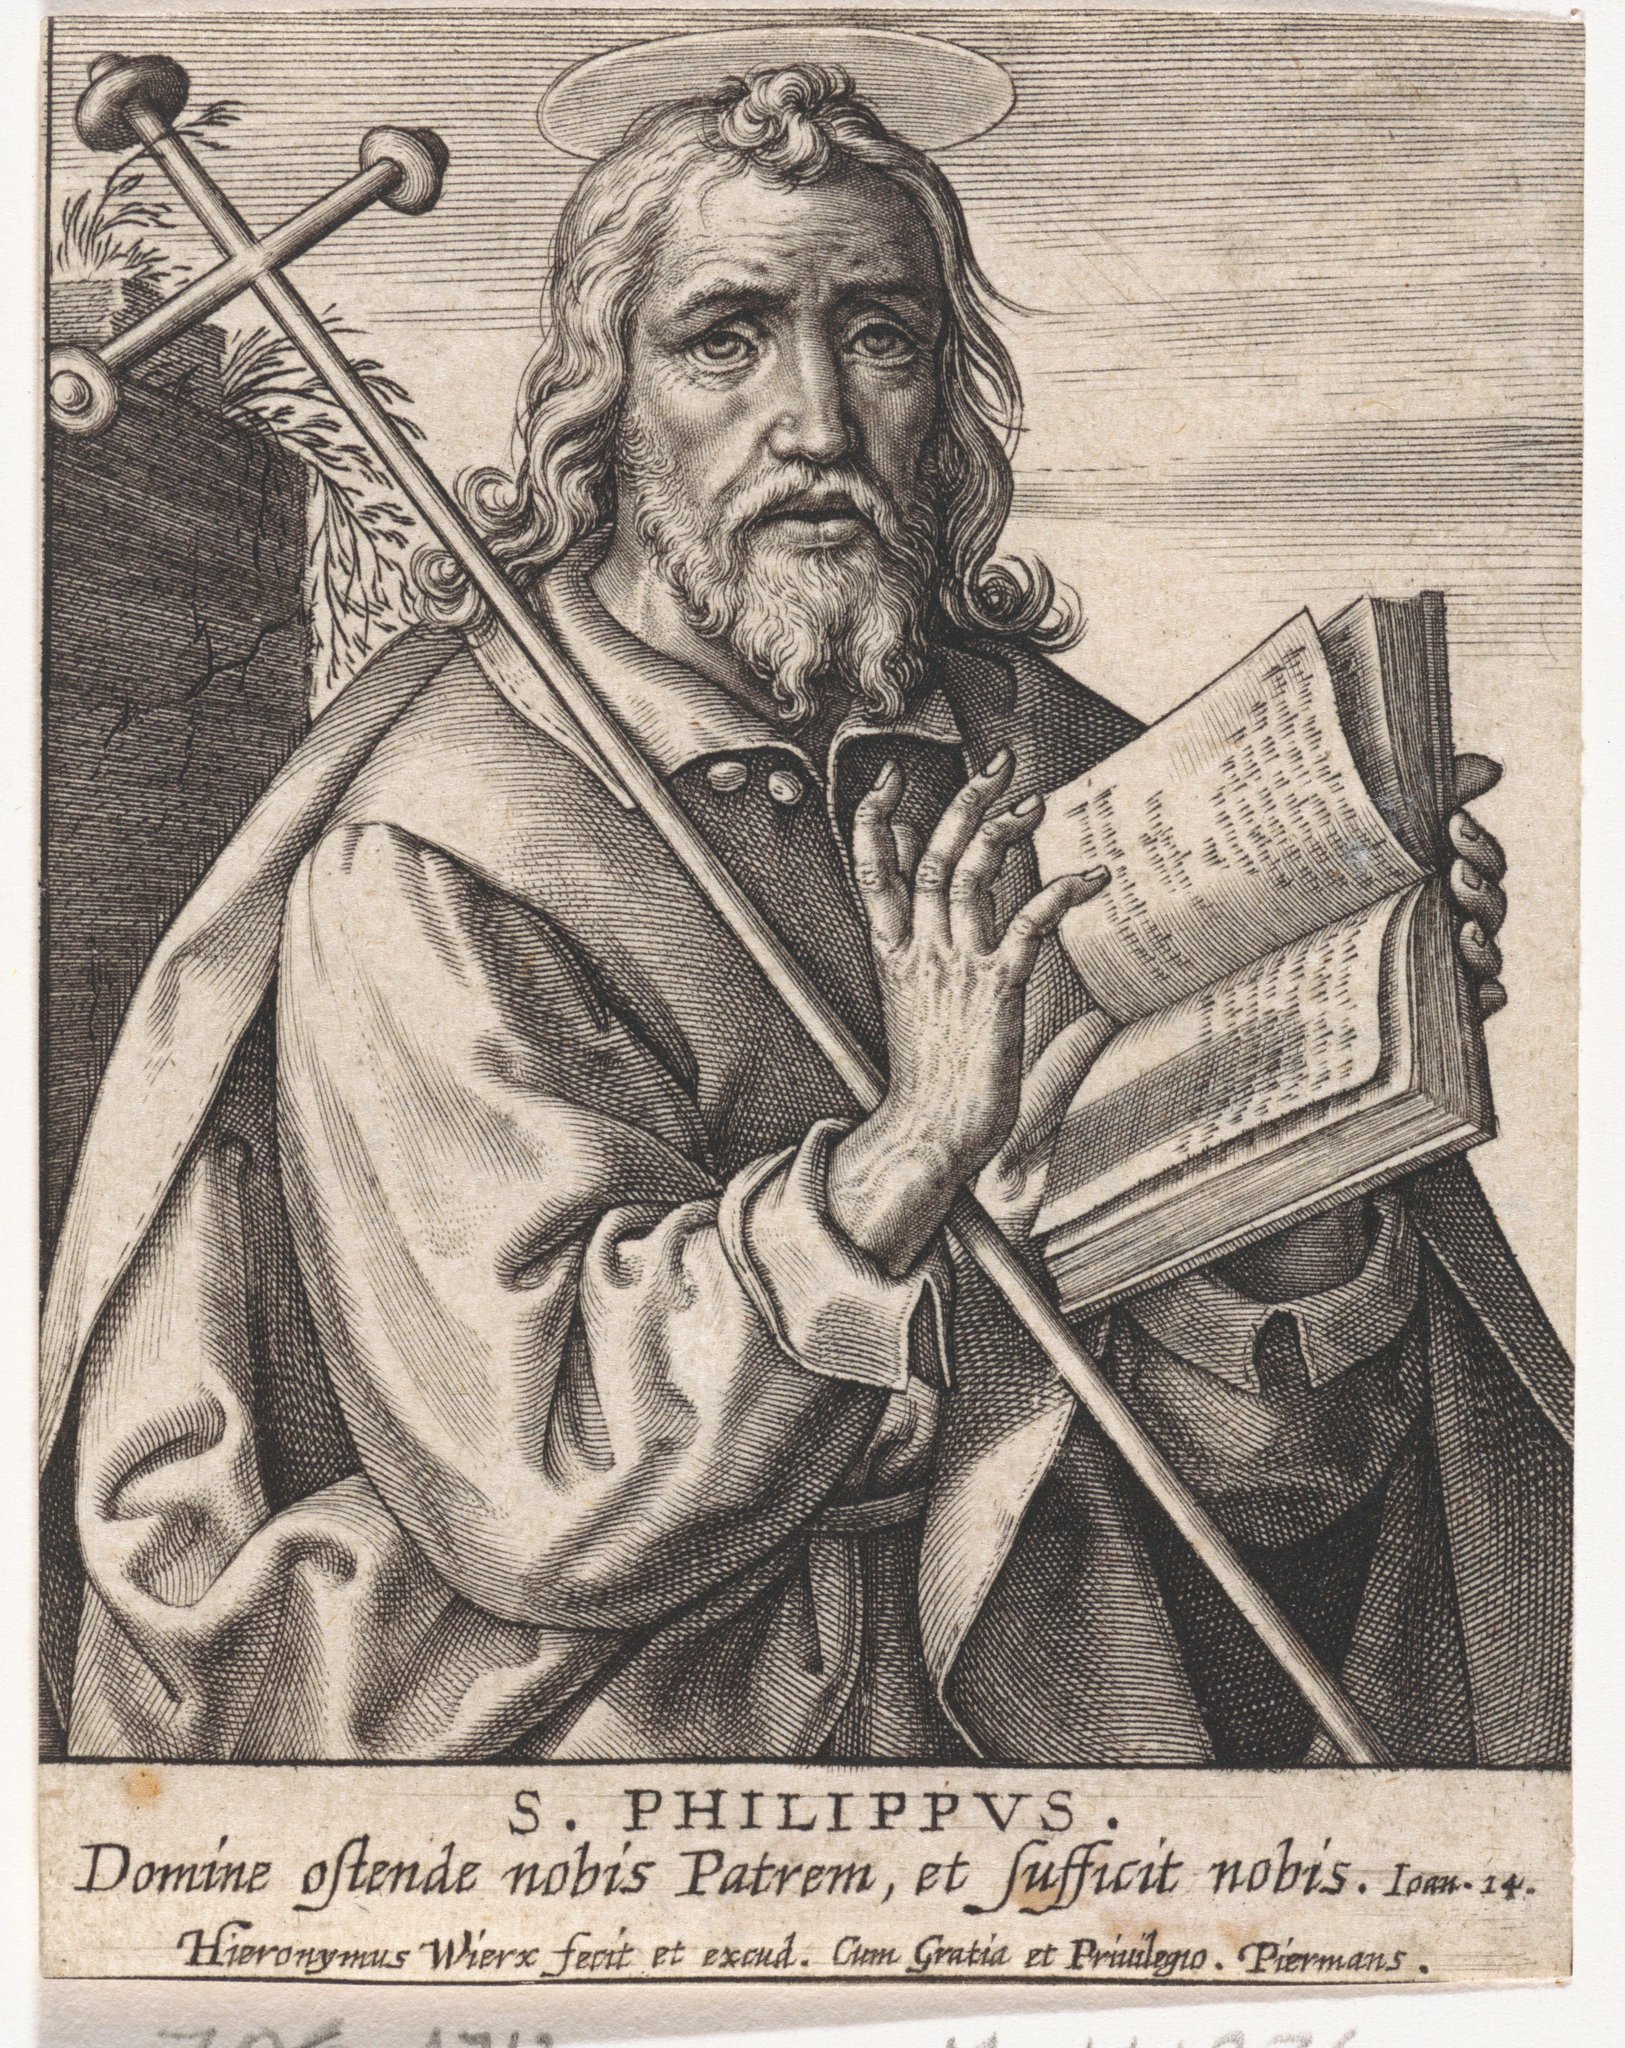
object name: print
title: H. Filippus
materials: paper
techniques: engraving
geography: antwerp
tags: the apostle philip; possible attributes: book, cross, dish with snake, lance, scroll, stone, sword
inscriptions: collector's mark: Lugt 240, number: ‘31’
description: De apostel Filippus, met een opengeslagen boek en een kruisstaf in de handen. In de marge een Bijbelcitaat uit Joh. 14 in het Latijn.